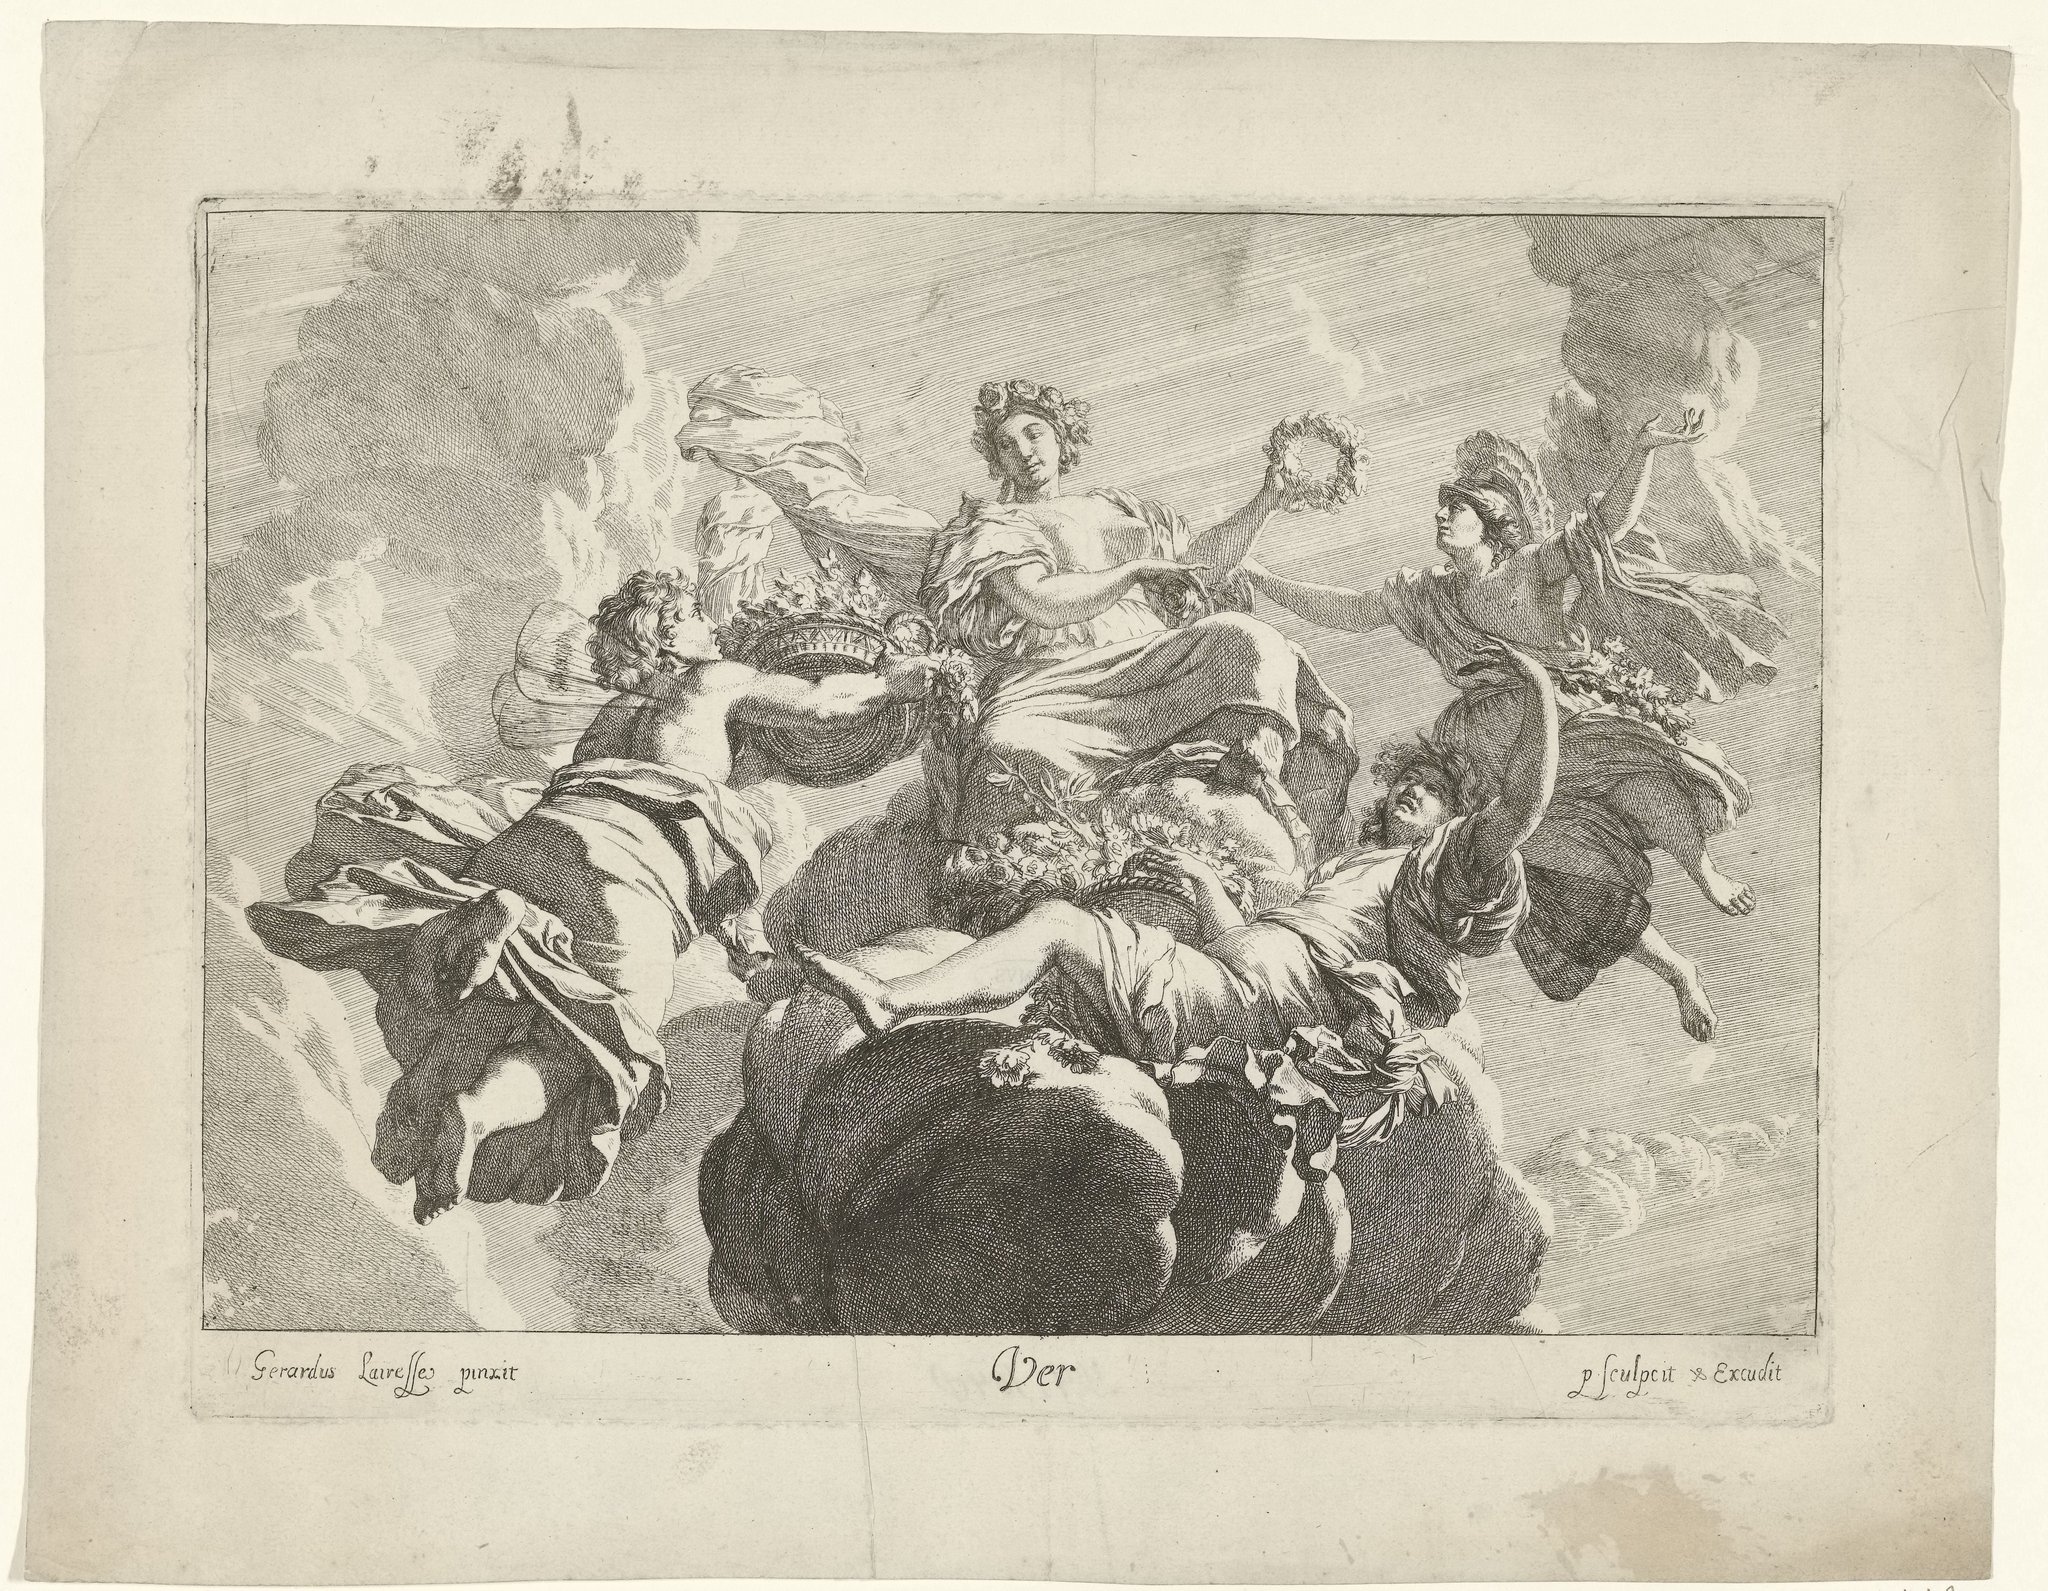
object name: print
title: Ver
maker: gerard de lairesse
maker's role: draughtsman, painter, print maker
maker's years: 1641-1711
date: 1675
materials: paper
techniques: etching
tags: spring, 'ver'; 'primavera' (ripa), (story of) flora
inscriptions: collector's mark: Lugt 2228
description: Flora zit als personificatie van de lente op een wolk en is omgeven door drie gepersonifieerde maanden die gebladerte en bloemen bij zich dragen. Flora is gekroond met een bloemenkrans en maakt een tweede van de bloemen die de Maanden haar aanreiken. De prent maakt deel uit van een vierdelige serie prenten over de vier jaargetijden.